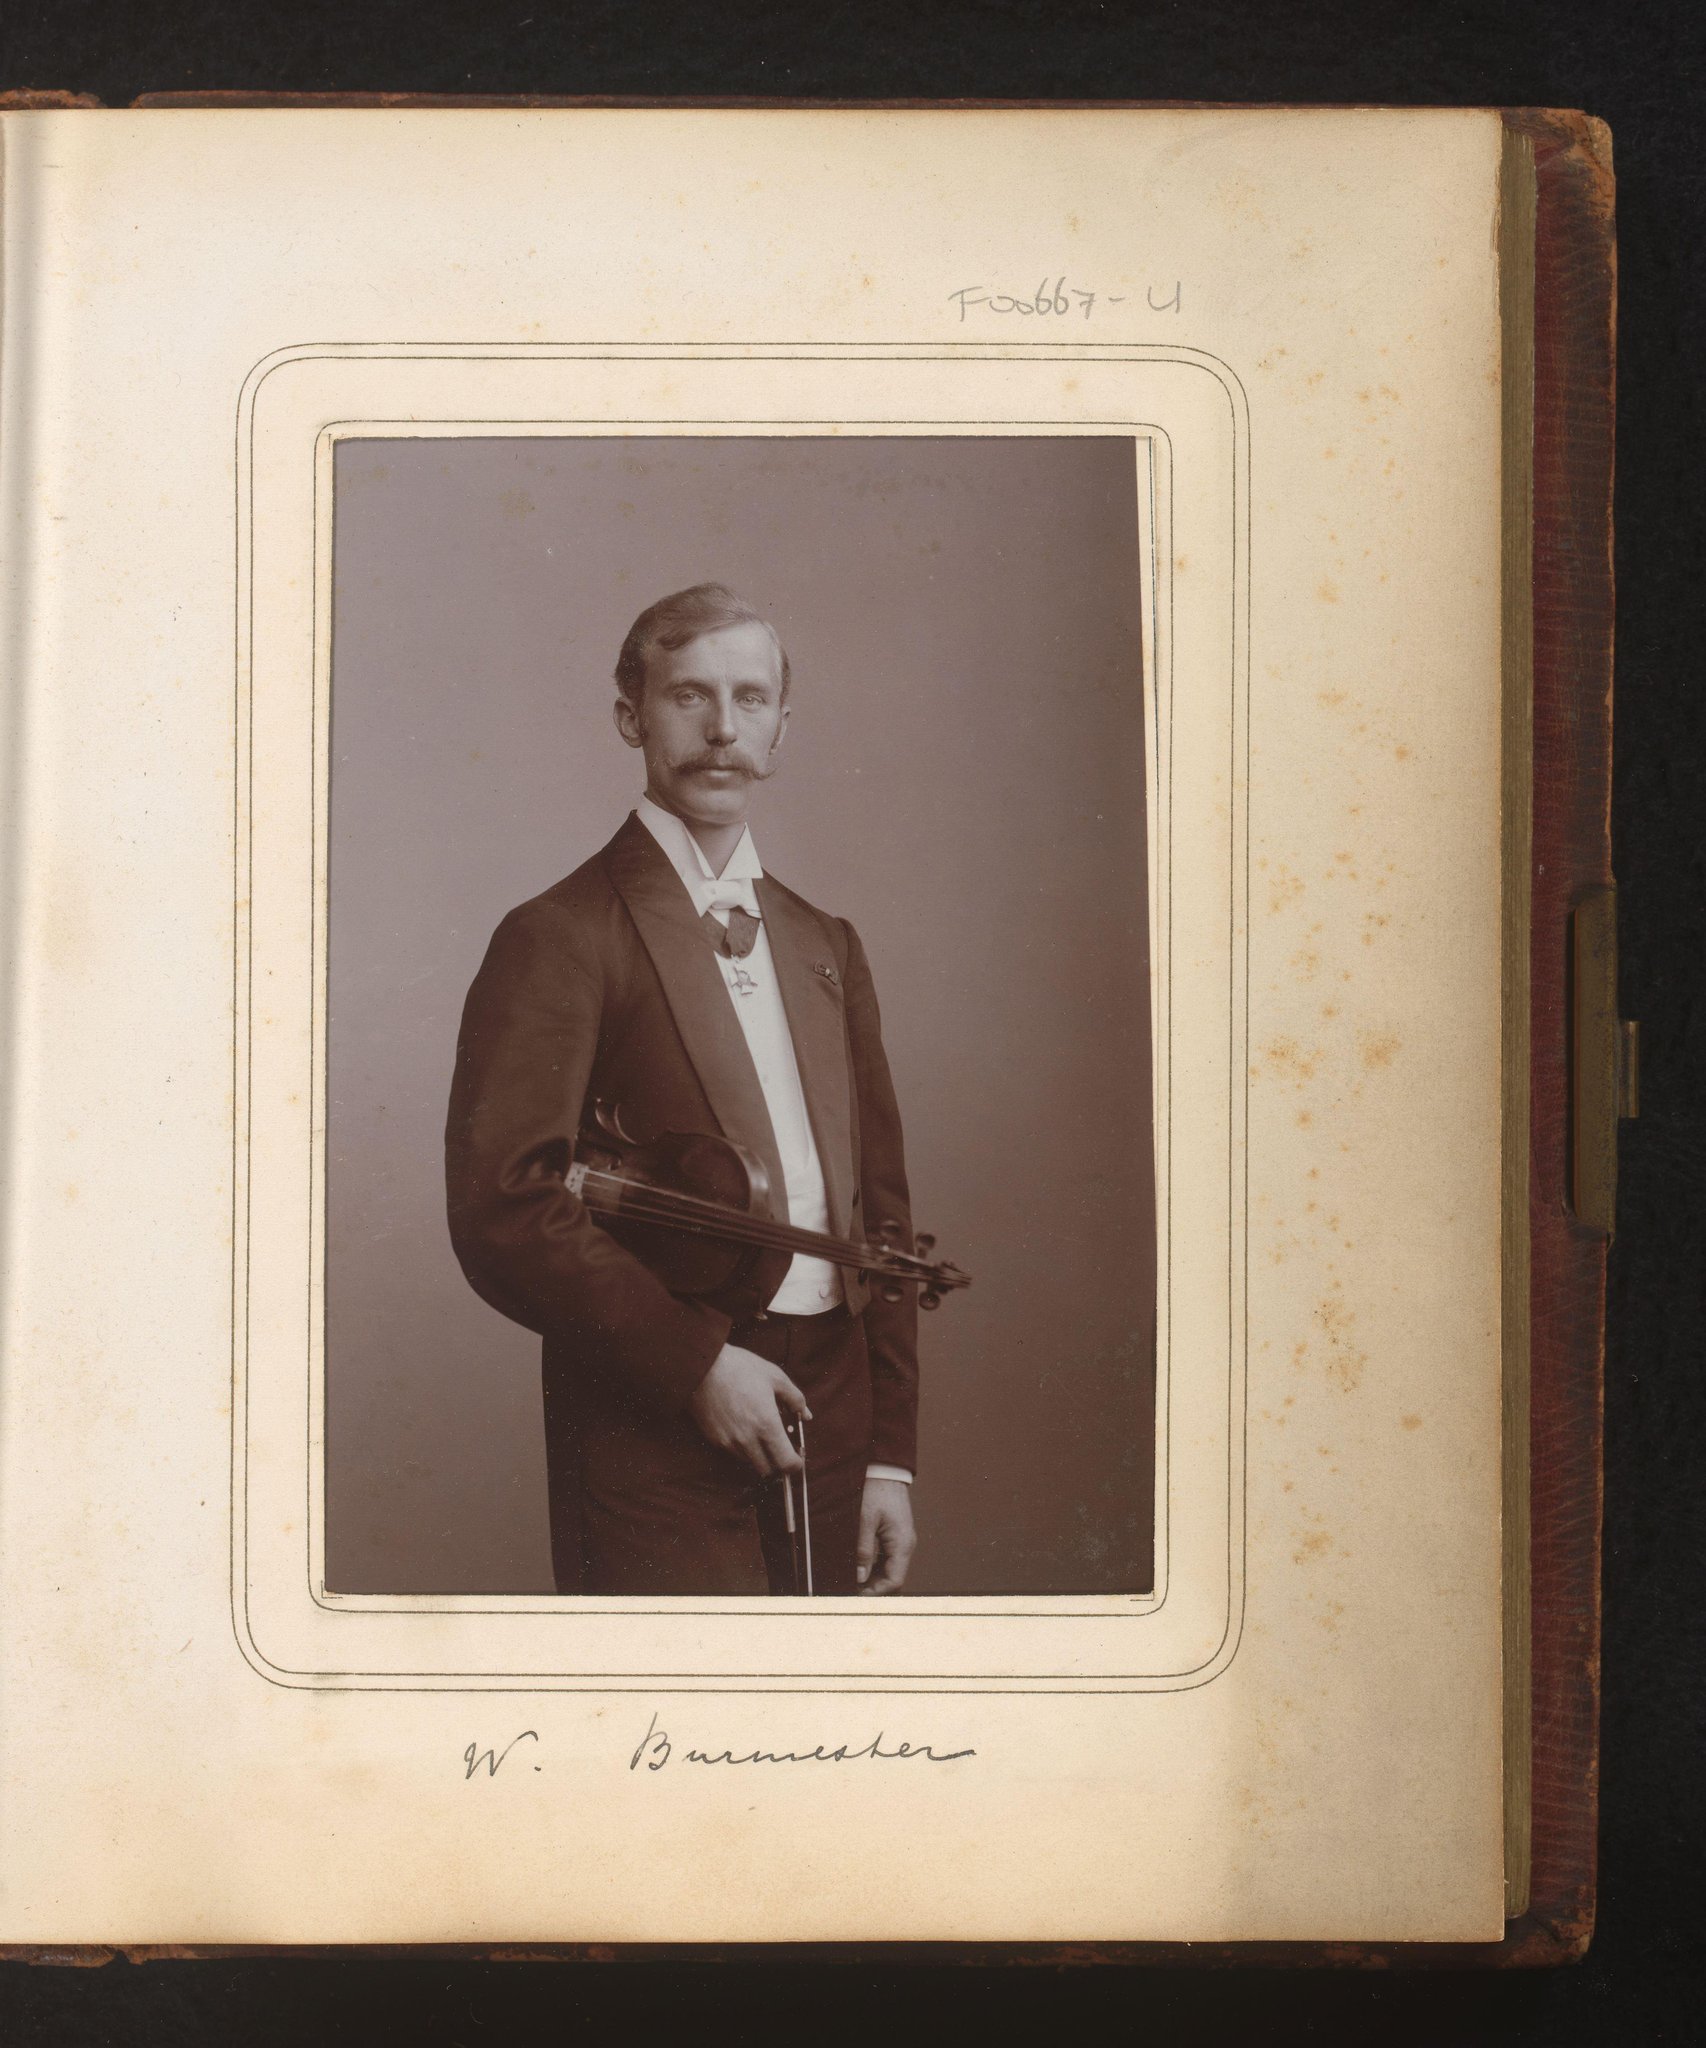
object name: cabinet photograph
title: Portret van Willy Burmester met viool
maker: julius cornelius schaarwächter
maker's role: fotograaf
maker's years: 1847-1904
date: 1900-1910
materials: cardboard, photographic support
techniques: albumen print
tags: musician, historical persons, violin, fiddle, portrait of composer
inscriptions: annotation: ‘W. Burmester’